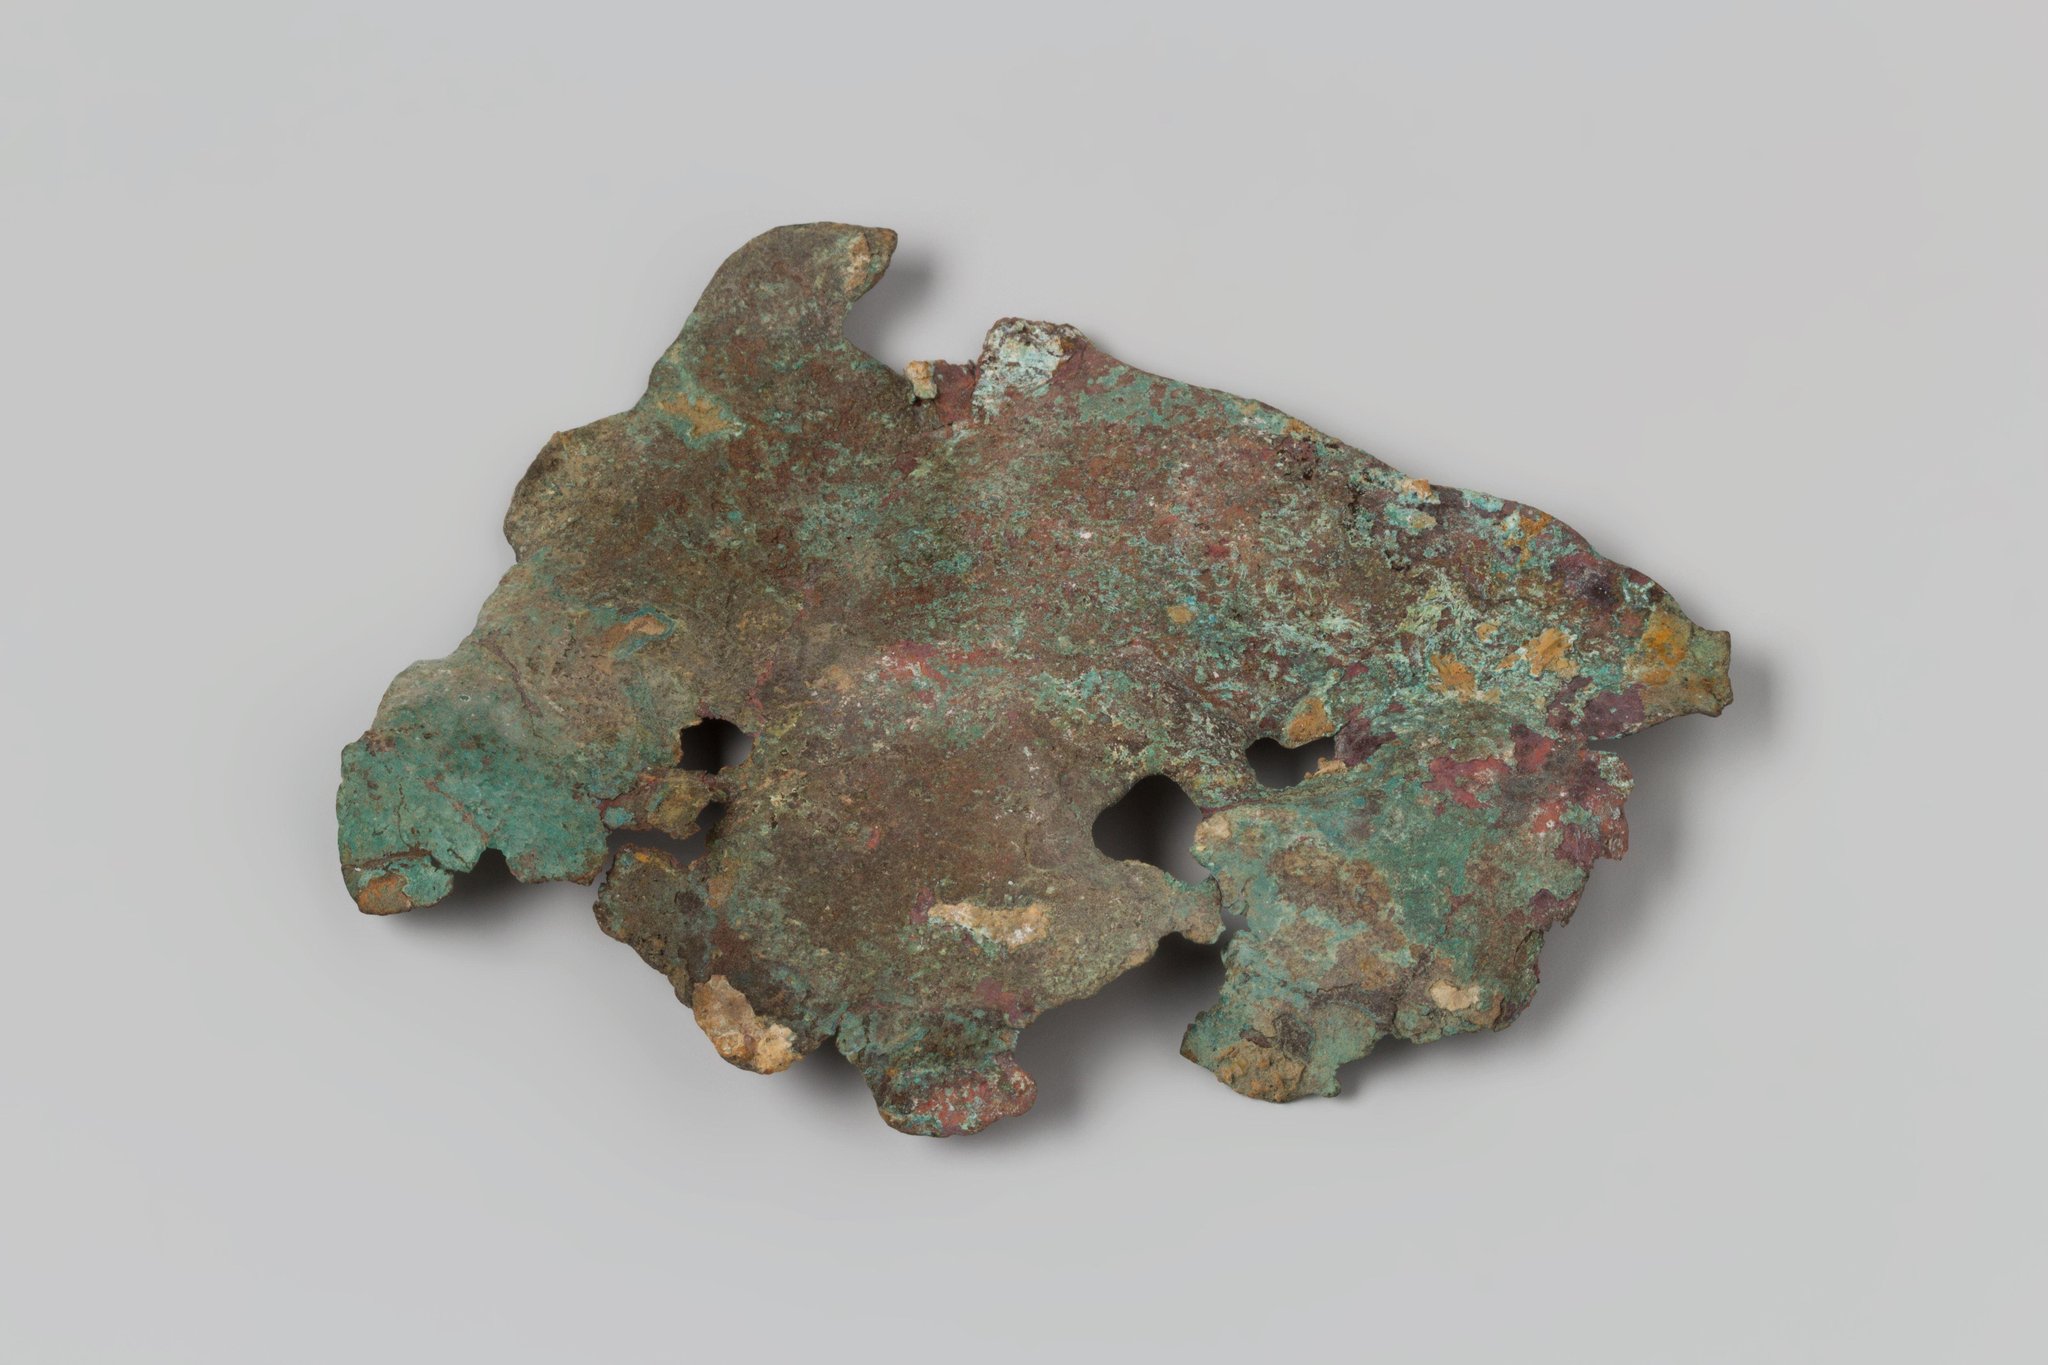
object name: scheepswrakvondst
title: Fragment van koper uit het wrak van de Oost-Indiëvaarder Hollandia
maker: Anonymous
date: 1700-1743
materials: copper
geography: netherlands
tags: verenigde oostindische compagnie, hollandia (schip), annet